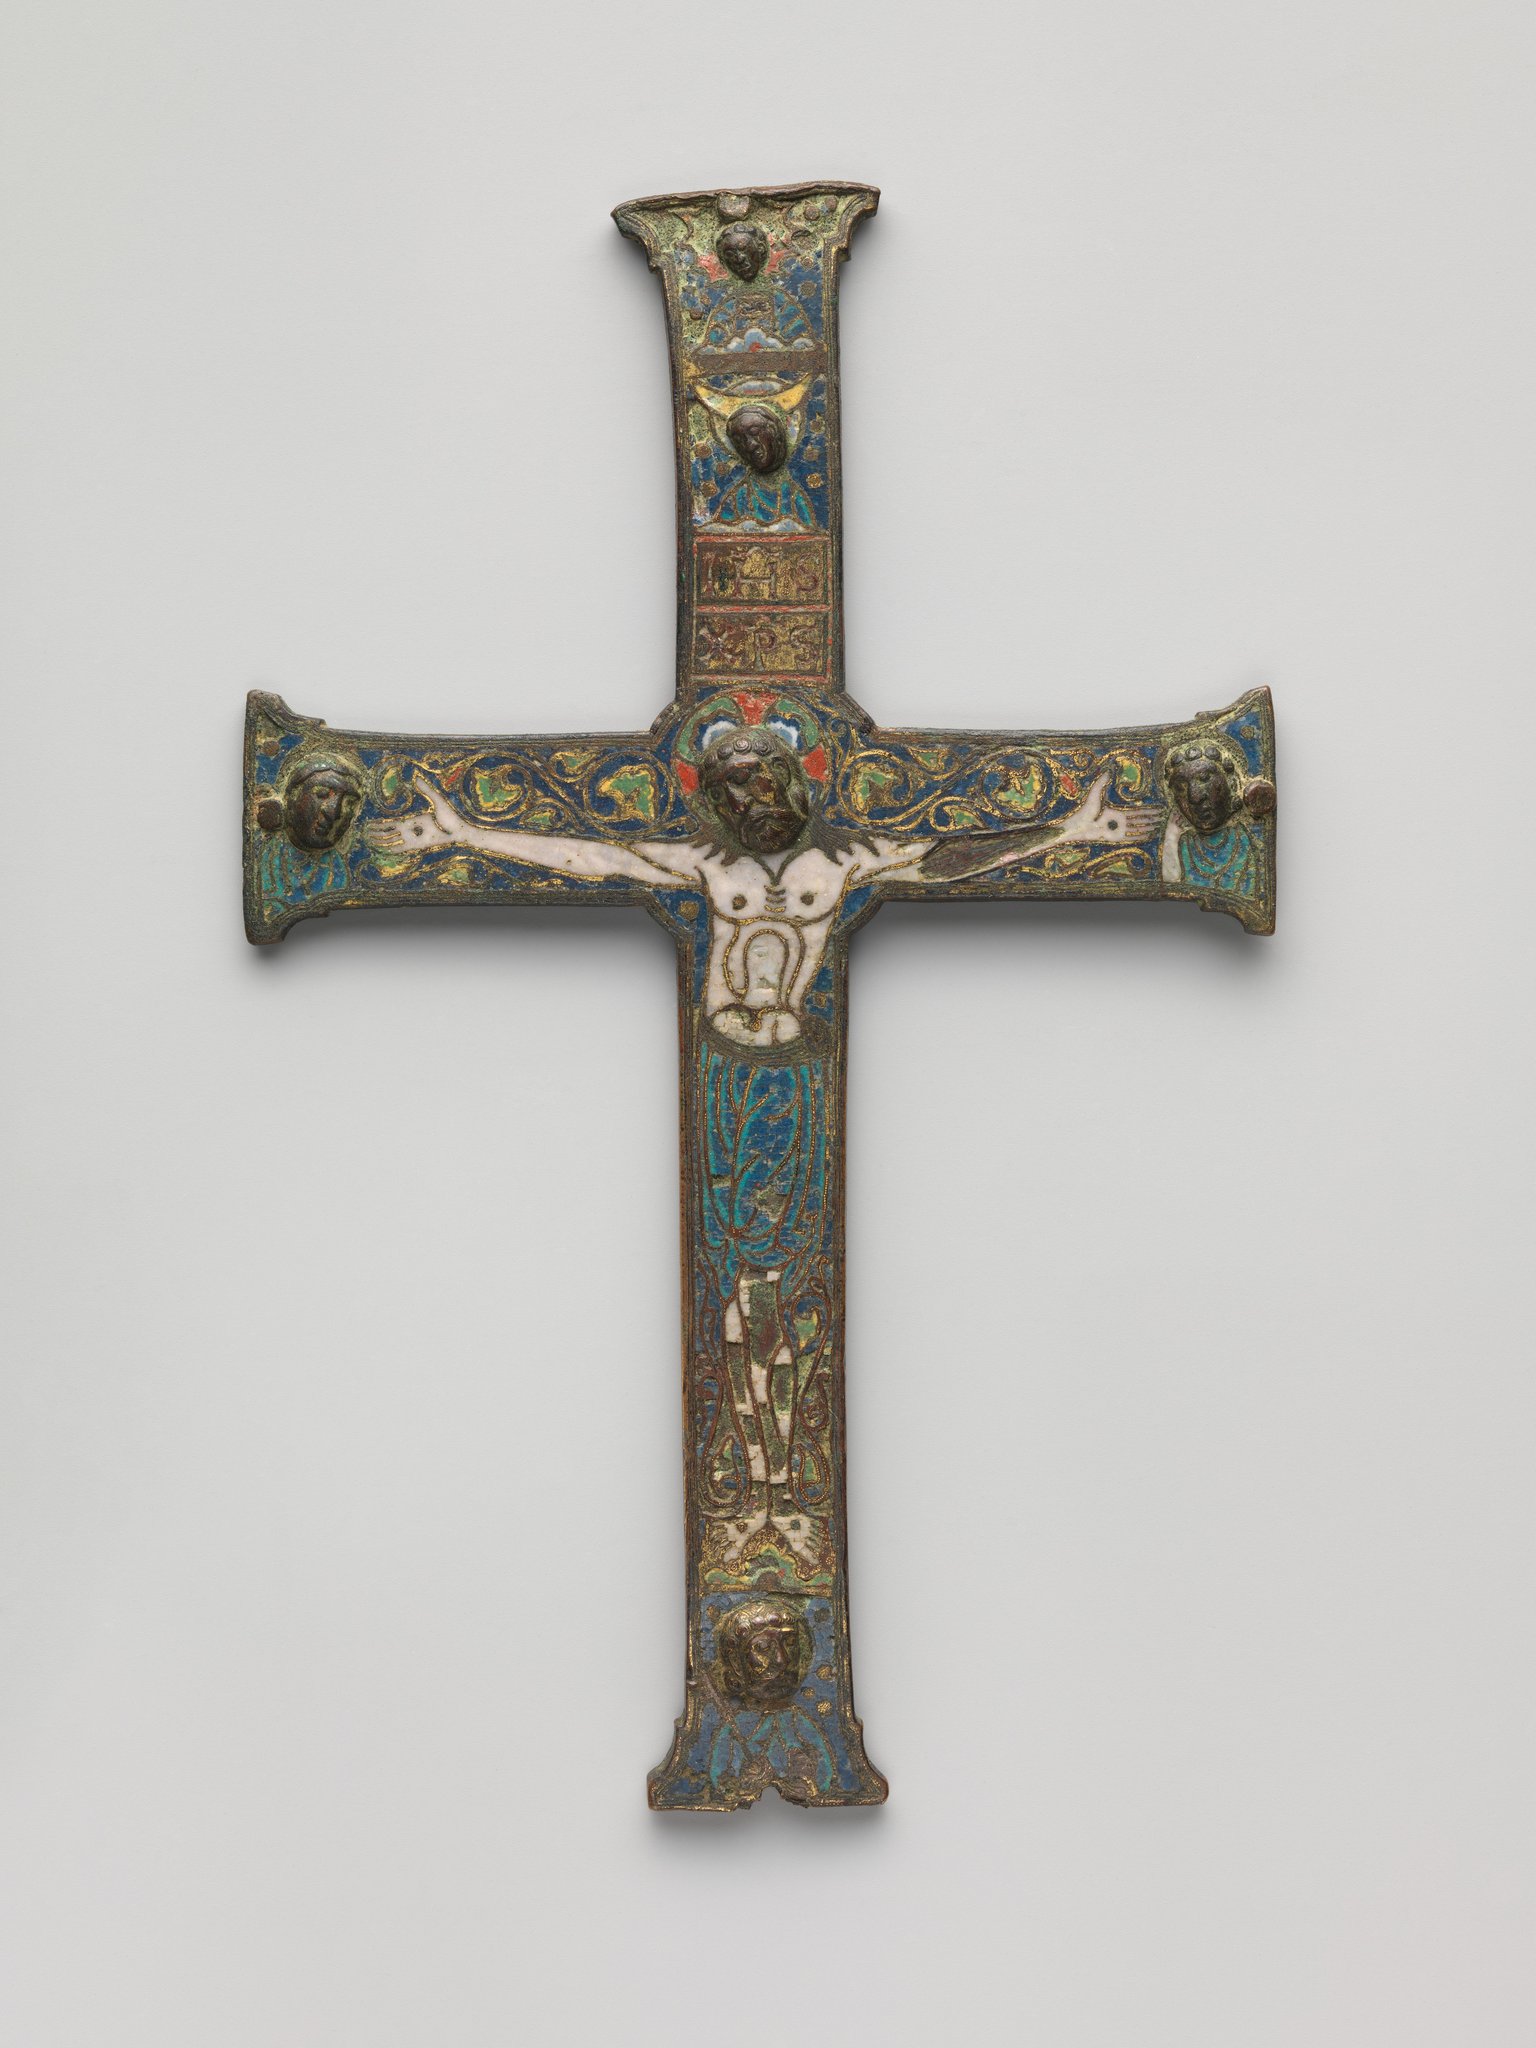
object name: crucifix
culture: french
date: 1180-1190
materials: gilt copper, enamel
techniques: enamel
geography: france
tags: christ